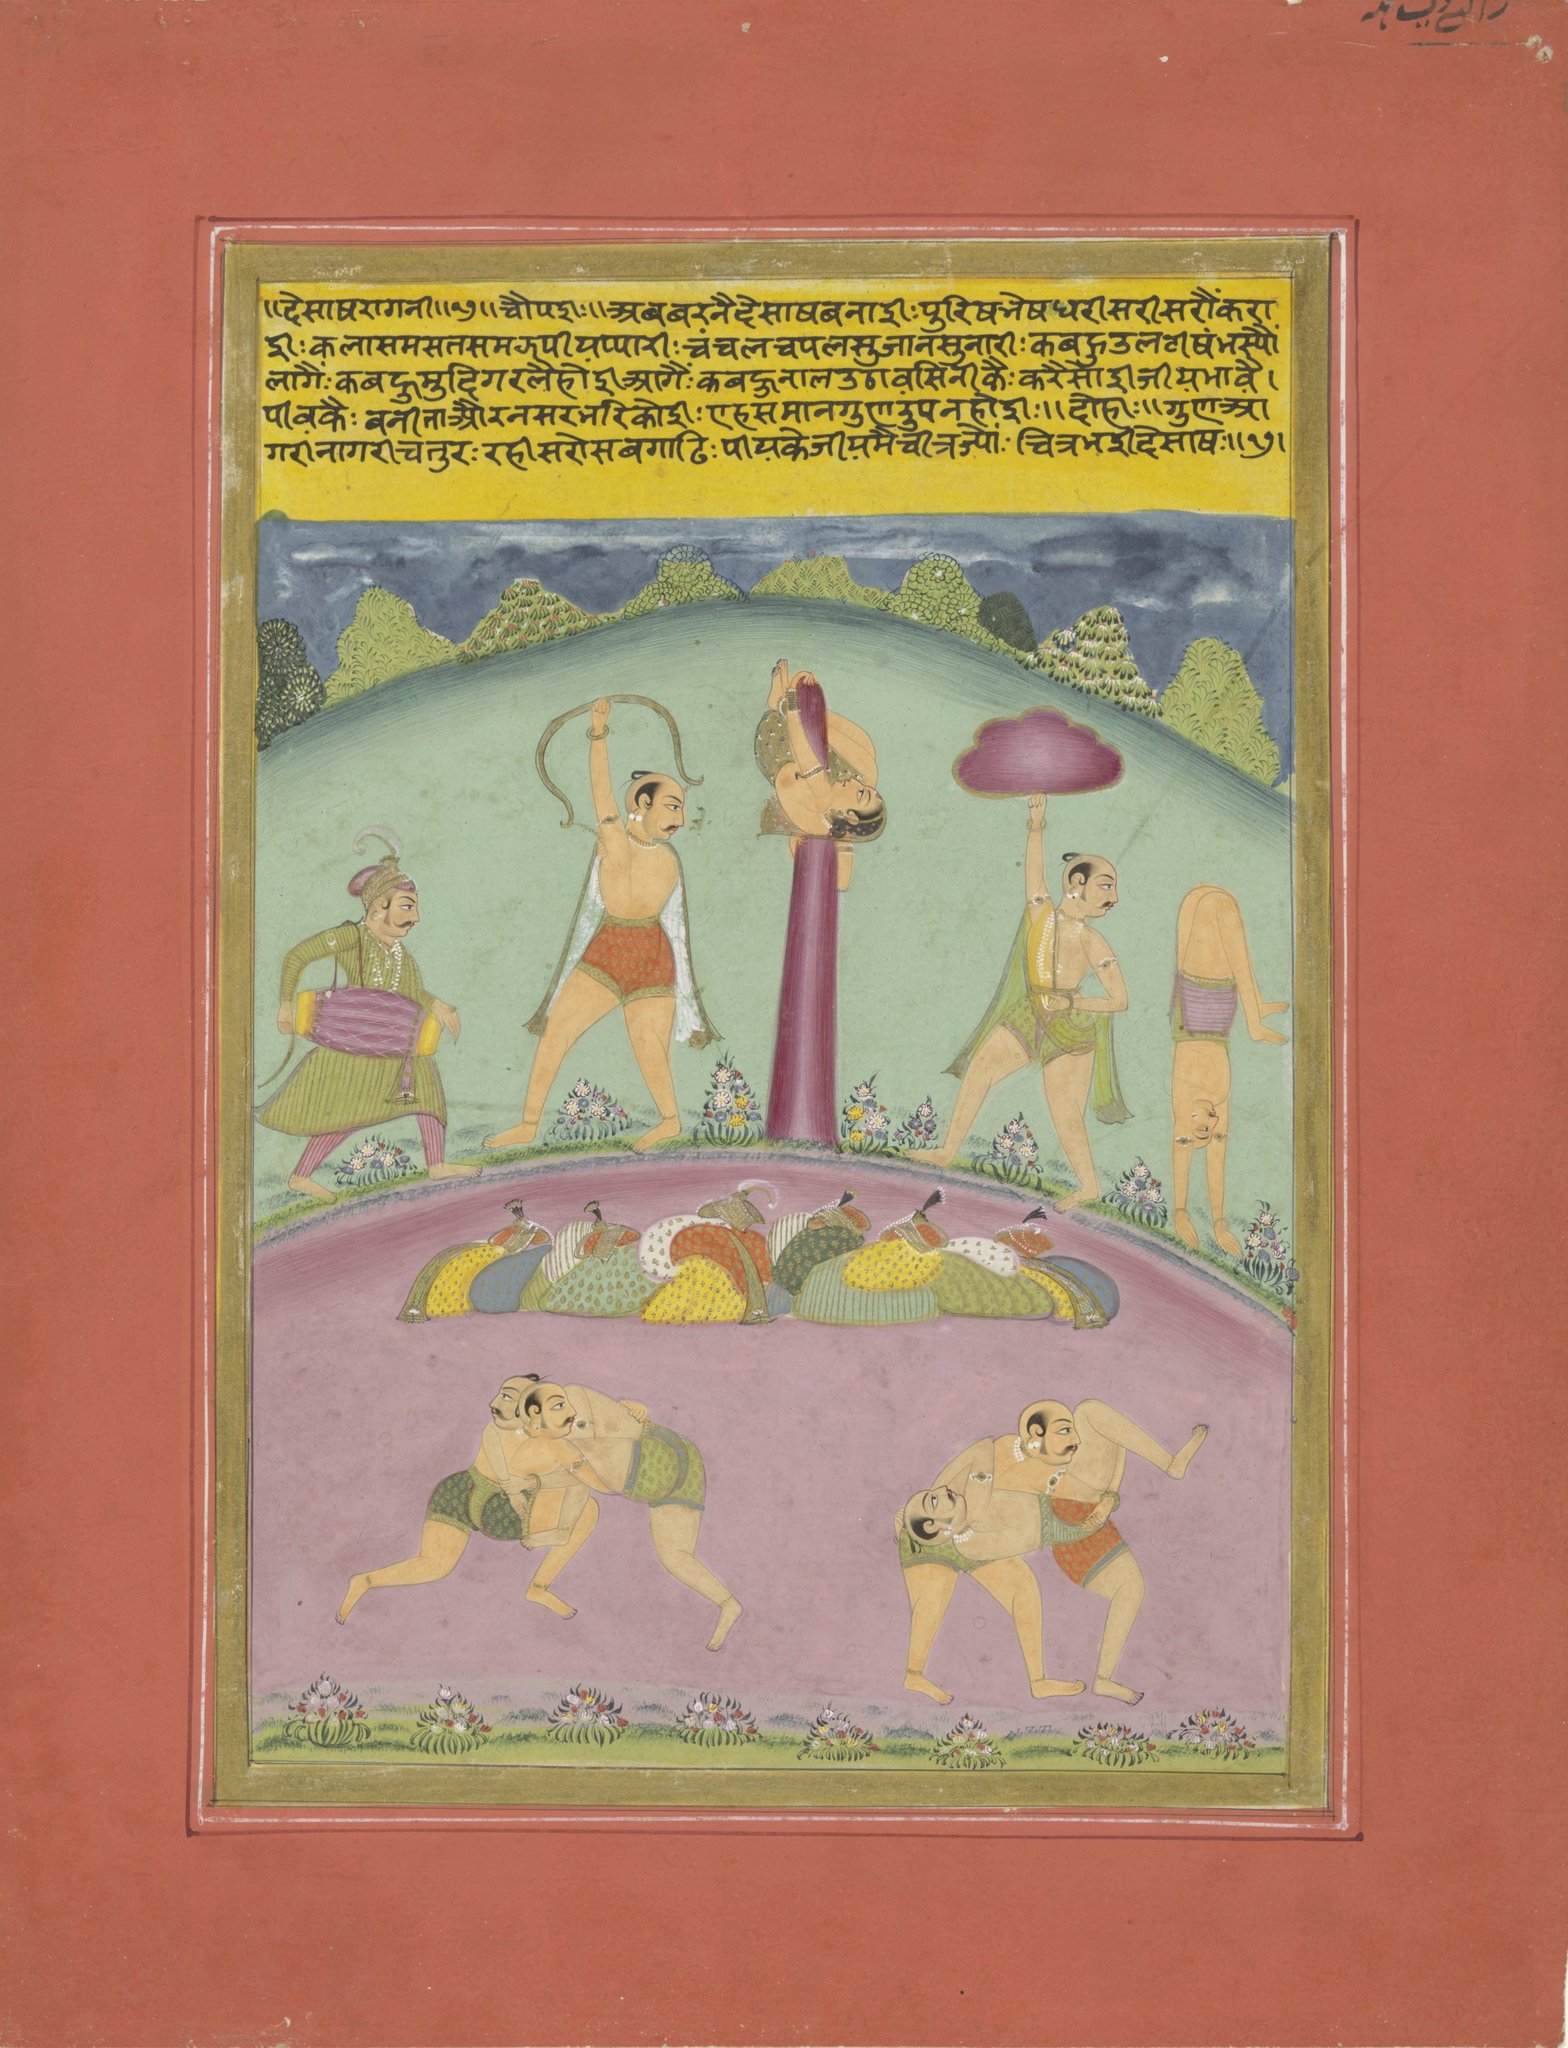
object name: indian miniature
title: Desakh raginii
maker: Anonymous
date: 1700-1800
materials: paper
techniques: brush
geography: jaipur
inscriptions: inscription